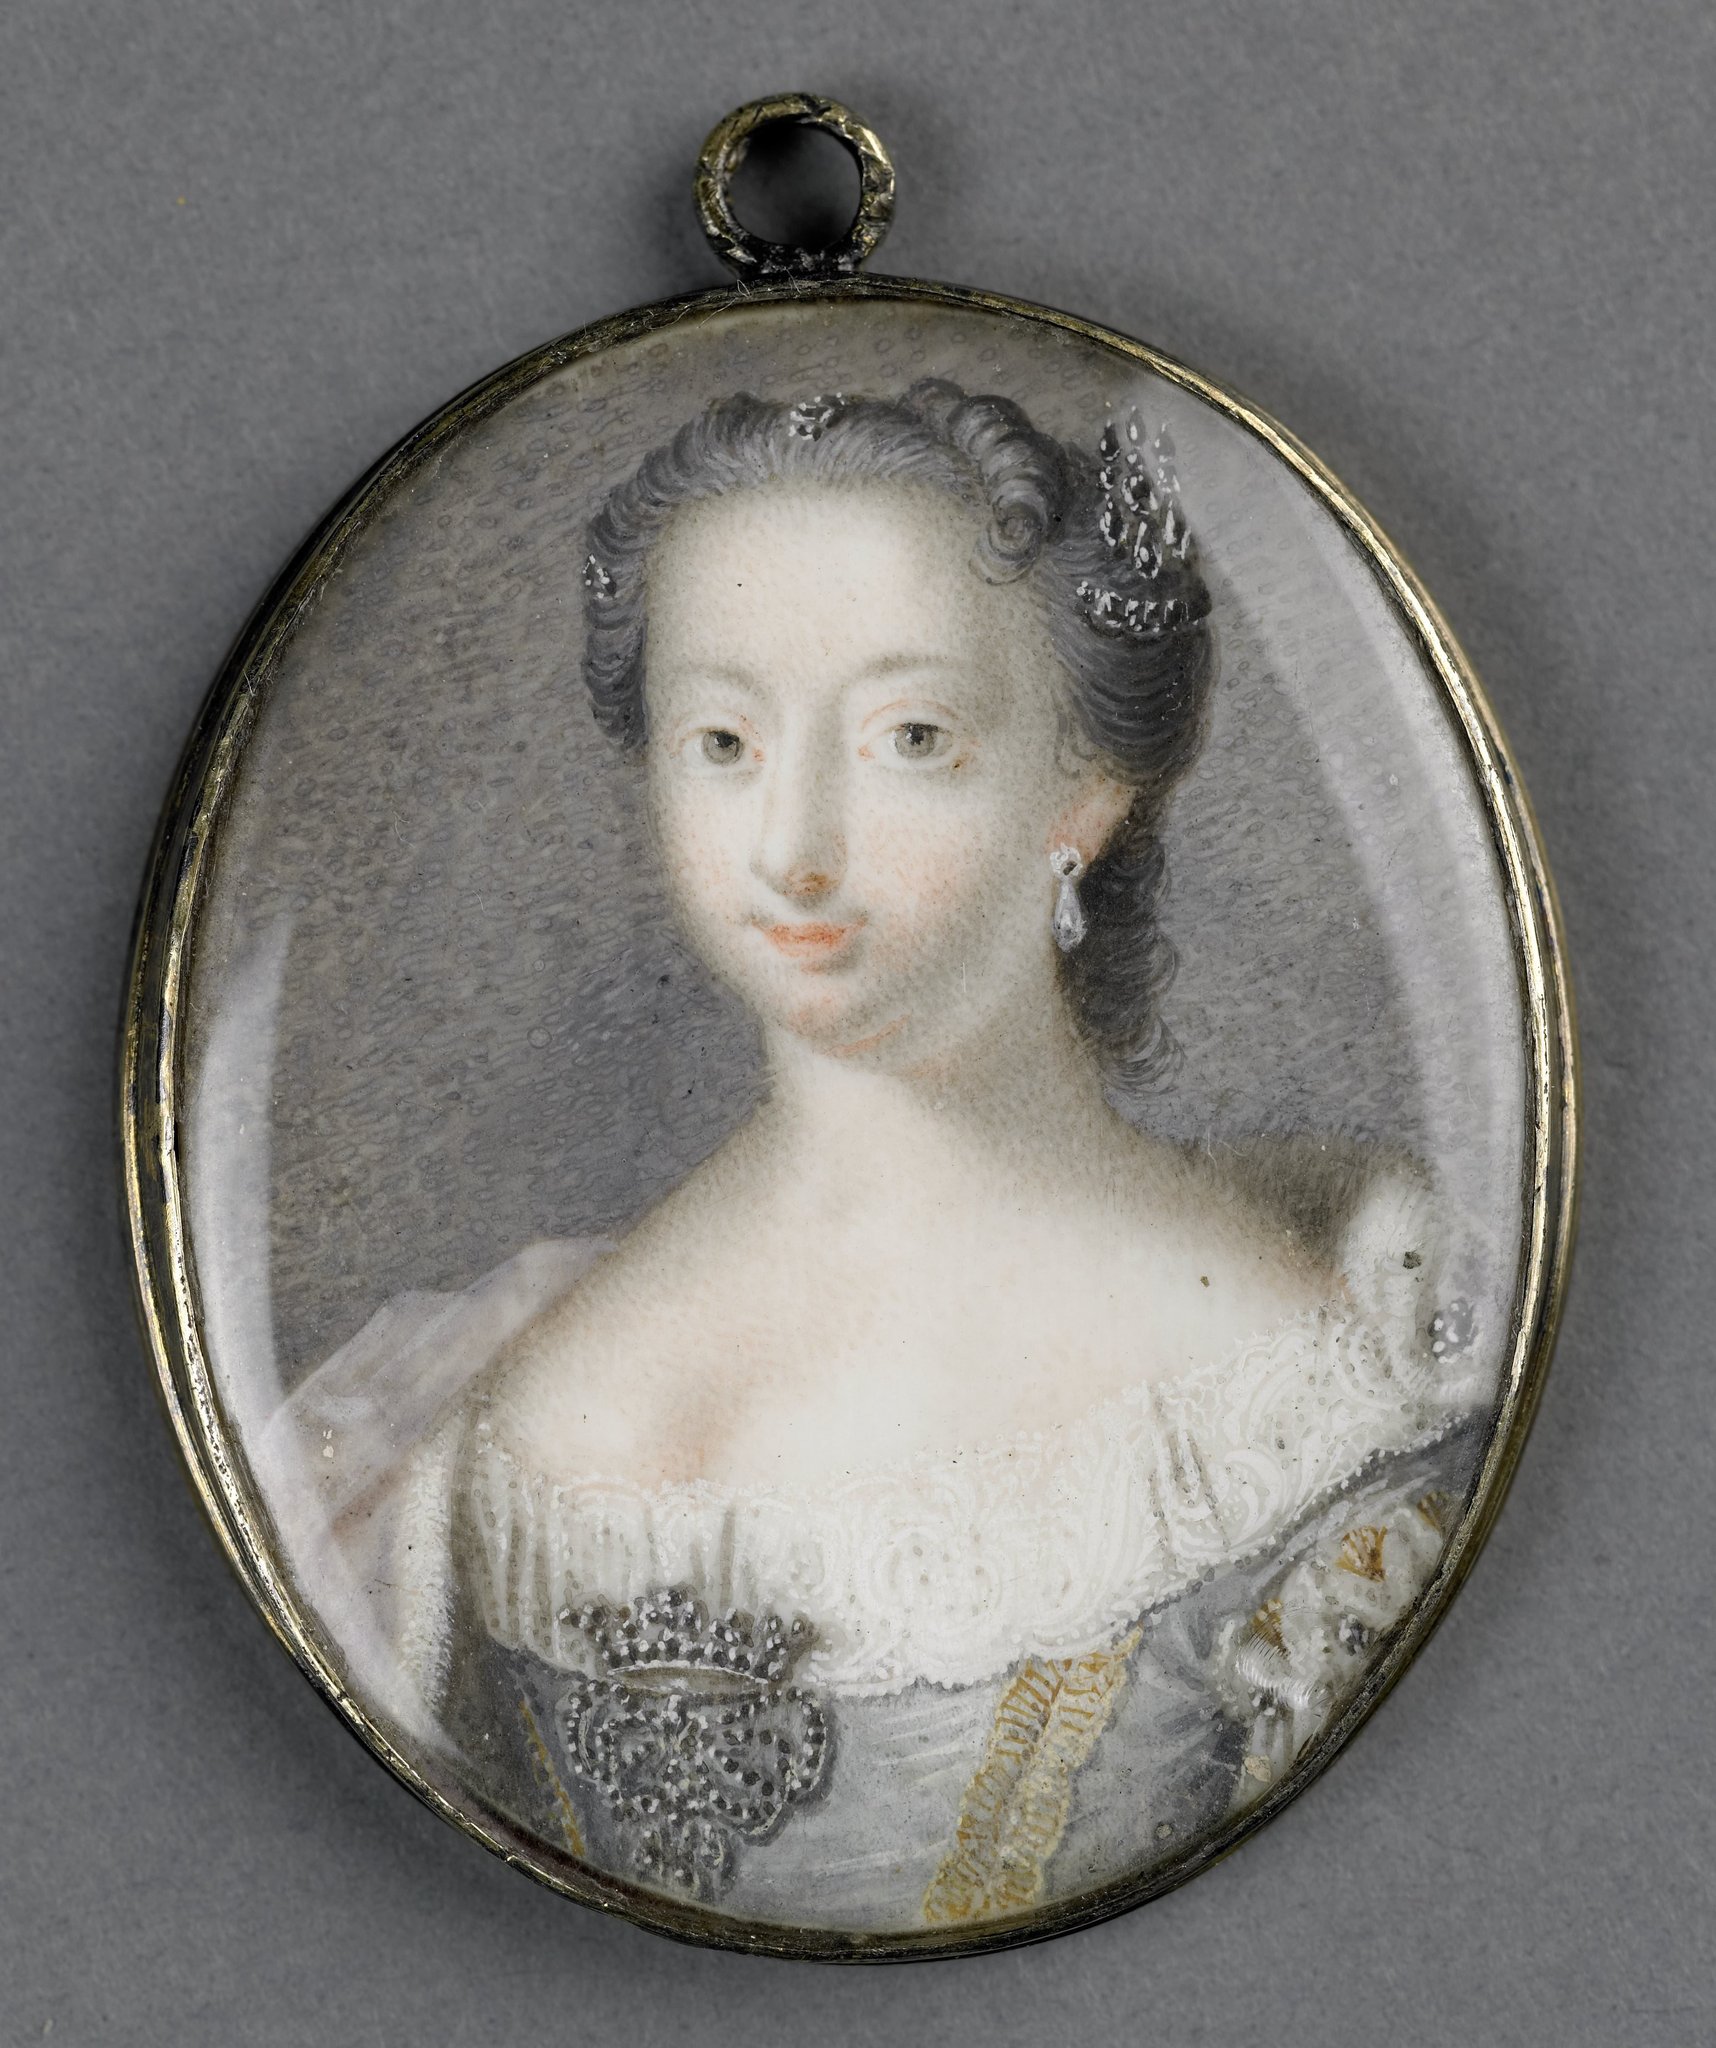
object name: painting, miniature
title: Anna van Hannover (1709-59). Echtgenote van prins Willem IV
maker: gerrit kamphuysen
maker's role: miniatuurschilder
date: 1753-1760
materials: glass, ivory, metal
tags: the hague, anna van hannover, historical persons - bb - woman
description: Anna of Hanover, wife of William IV.